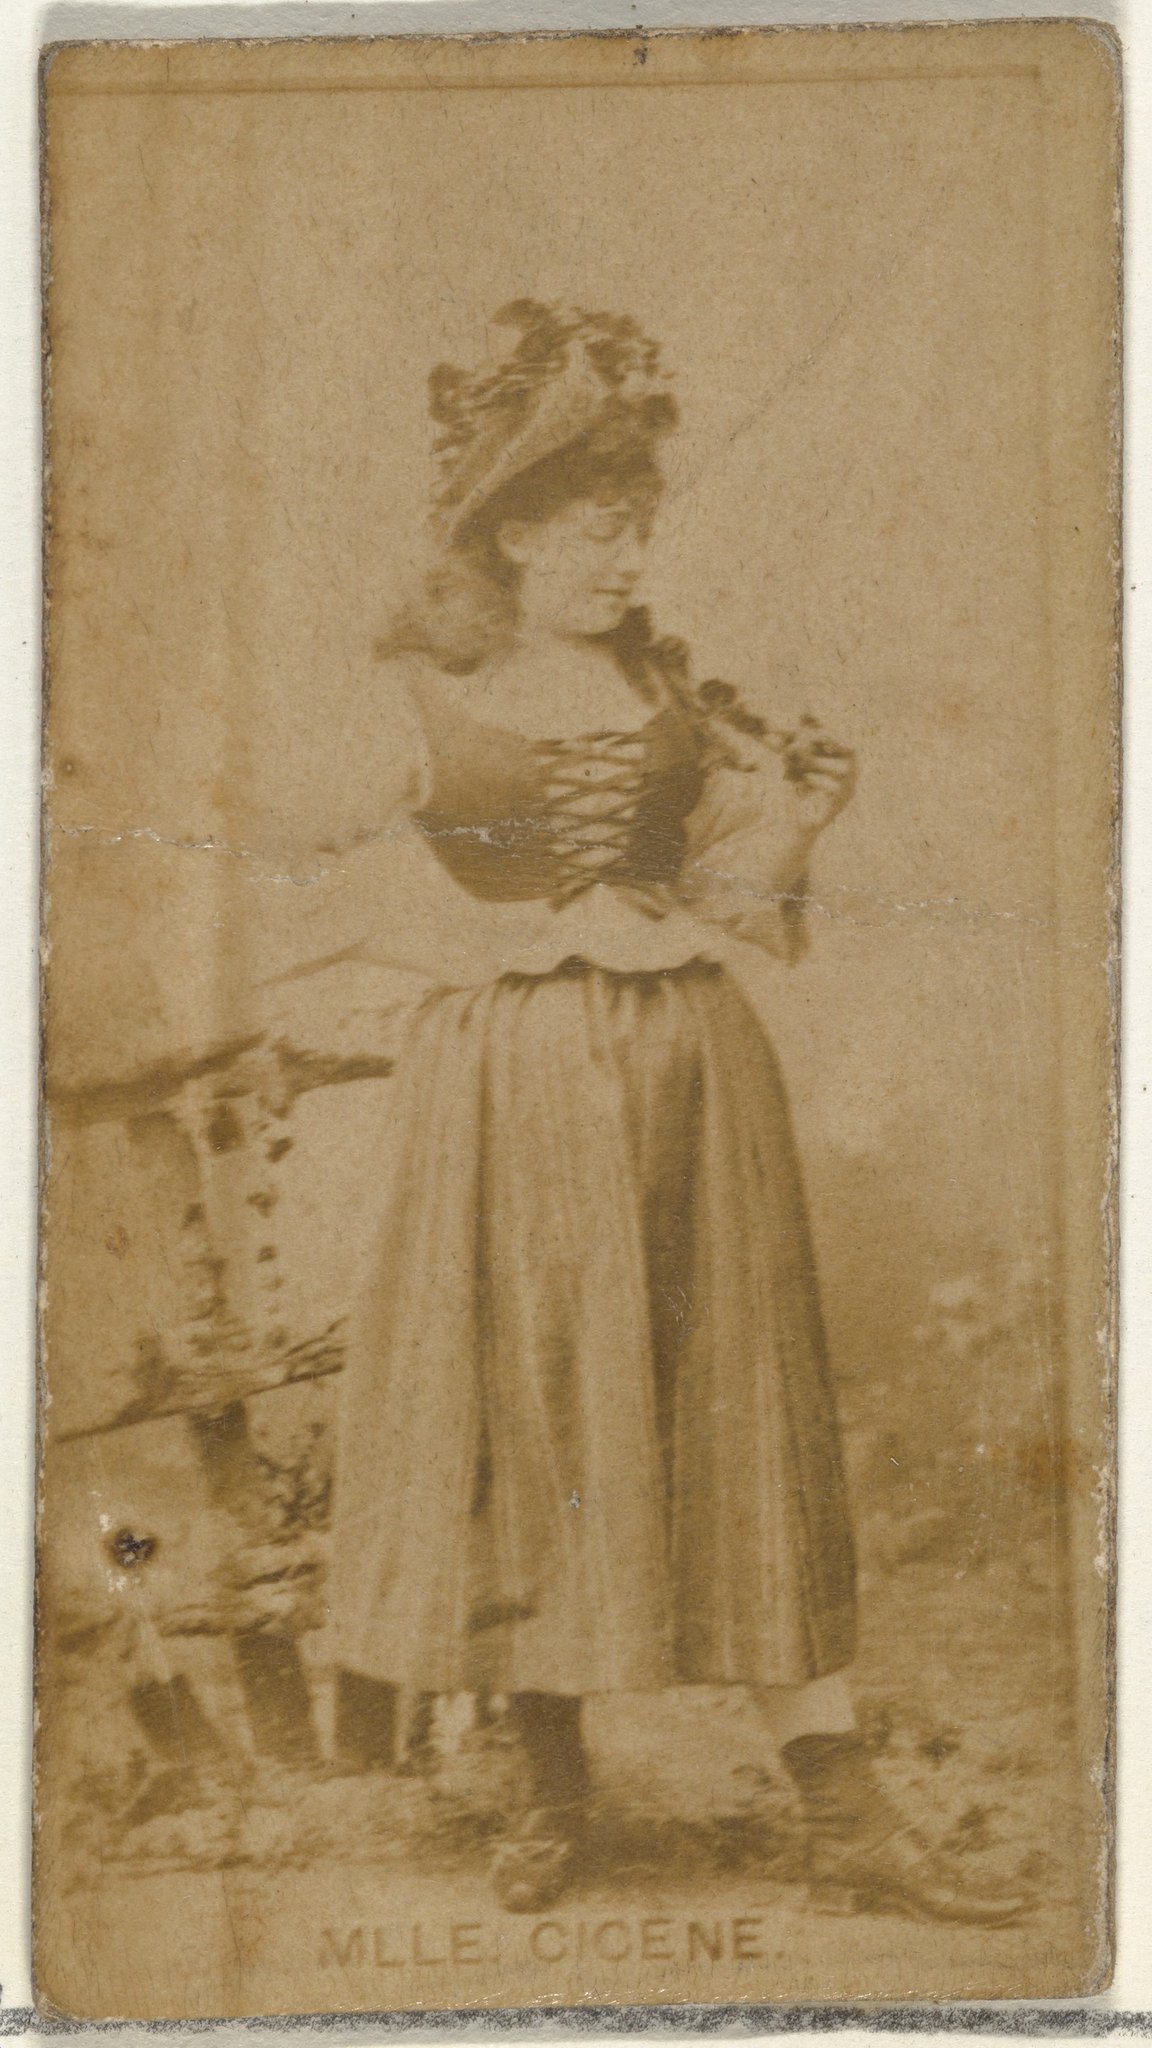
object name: photograph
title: Mlle. Cicene, from the Actors and Actresses series (N145-8) issued by Duke Sons & Co. to promote Duke Cigarettes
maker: w. duke, sons & co.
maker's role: publisher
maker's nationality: american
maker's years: 1870-1920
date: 1891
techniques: albumen silver print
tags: portraits,women,actresses